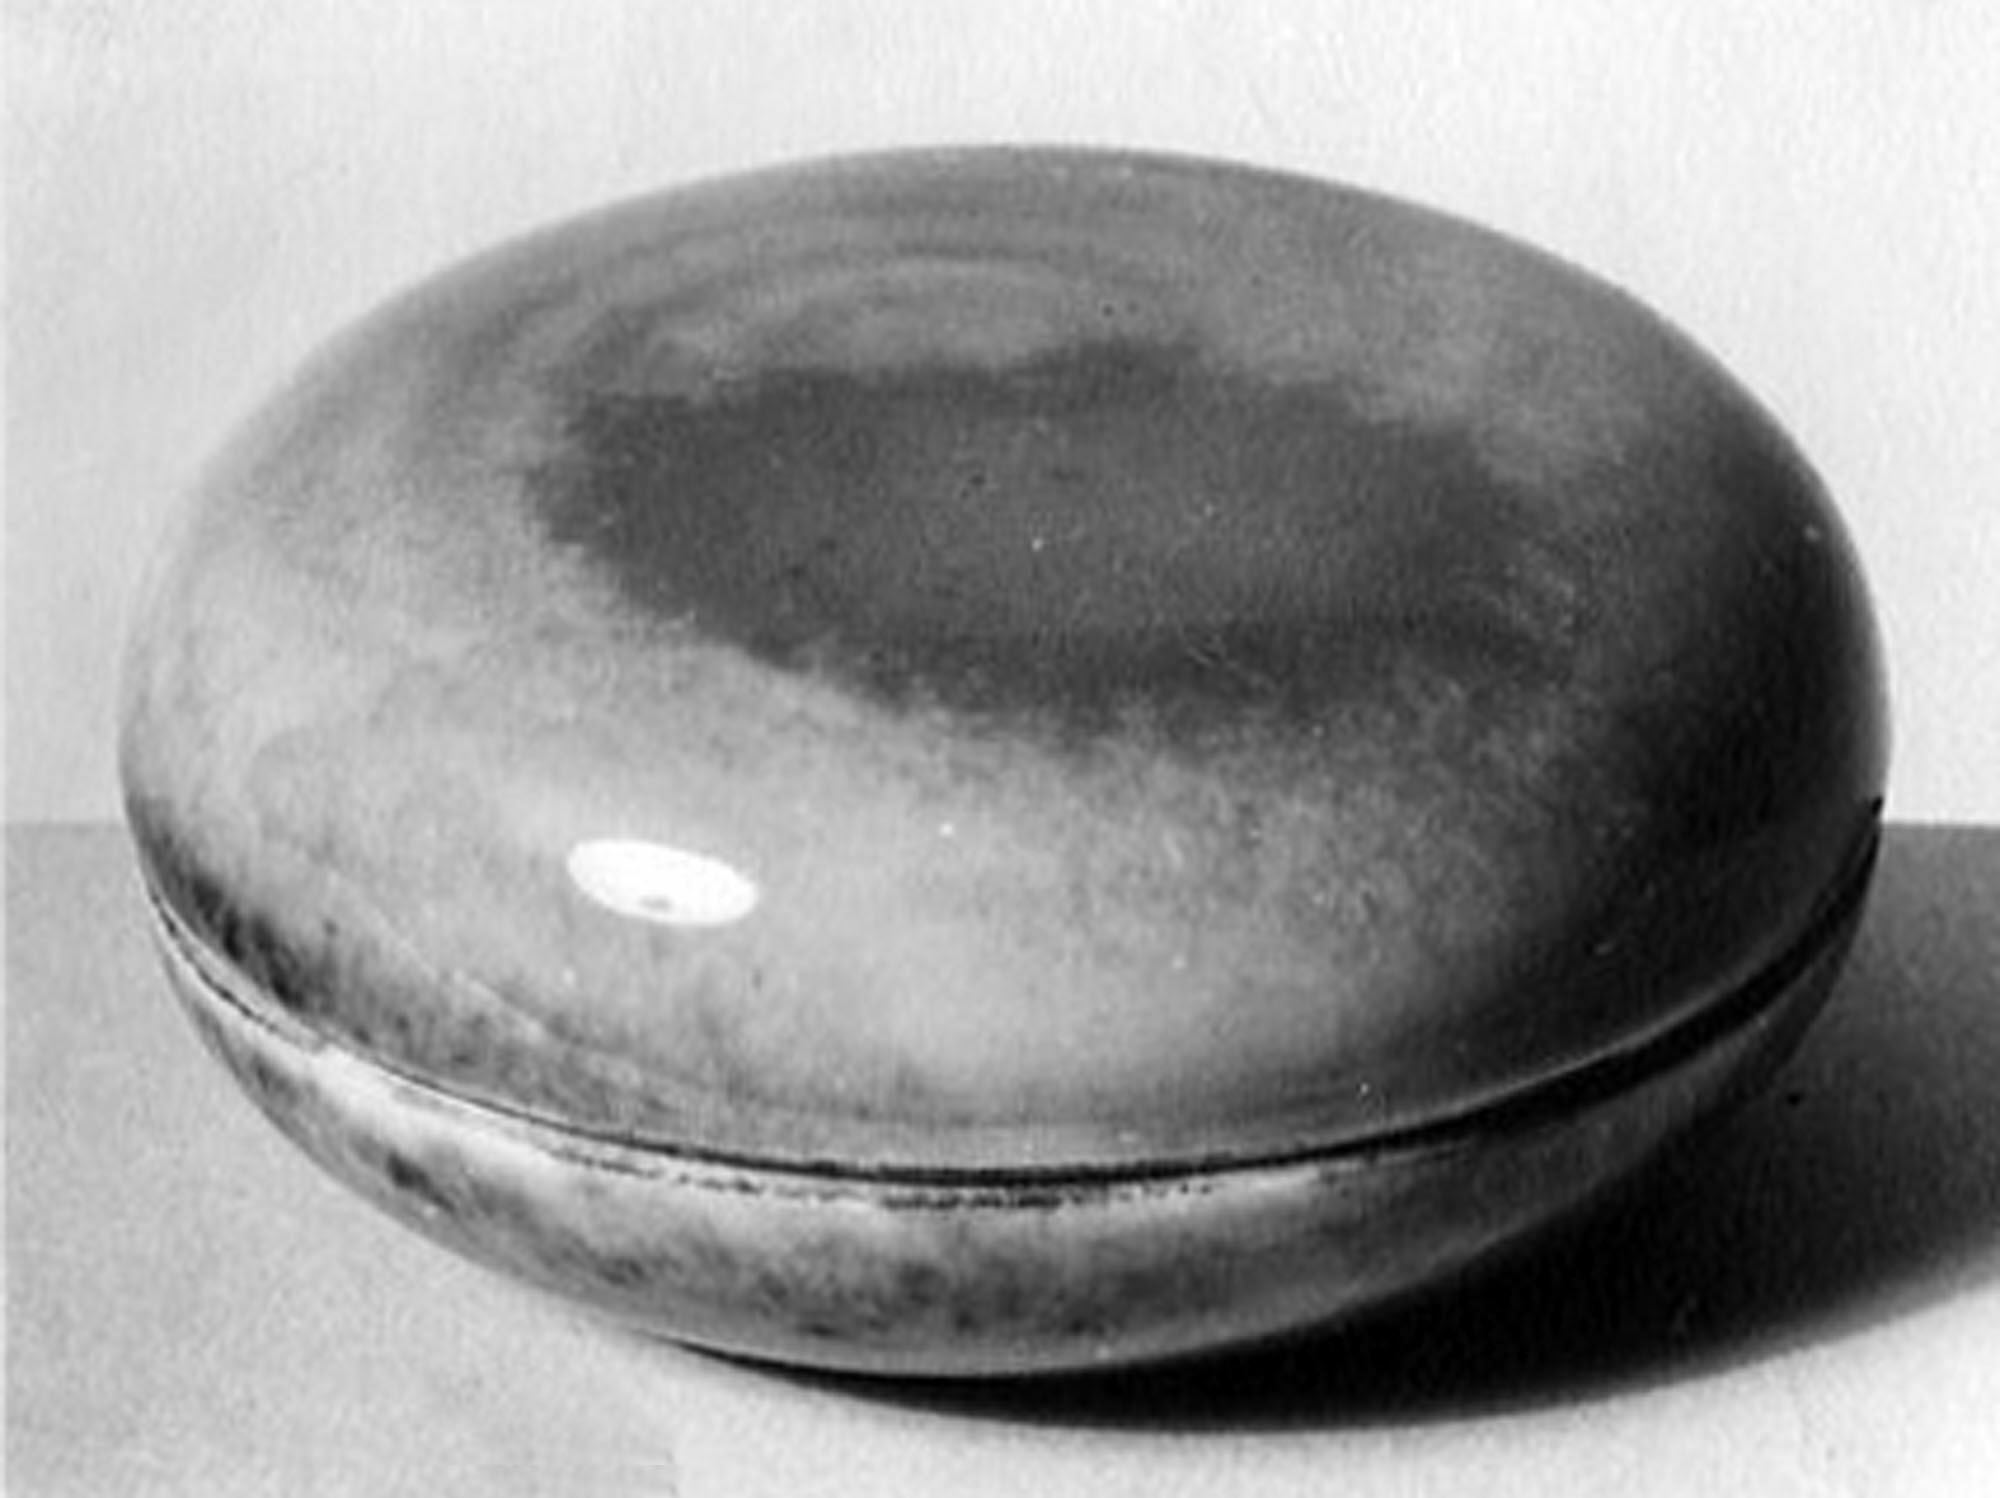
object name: box with cover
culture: chinese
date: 1662-1722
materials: porcelain